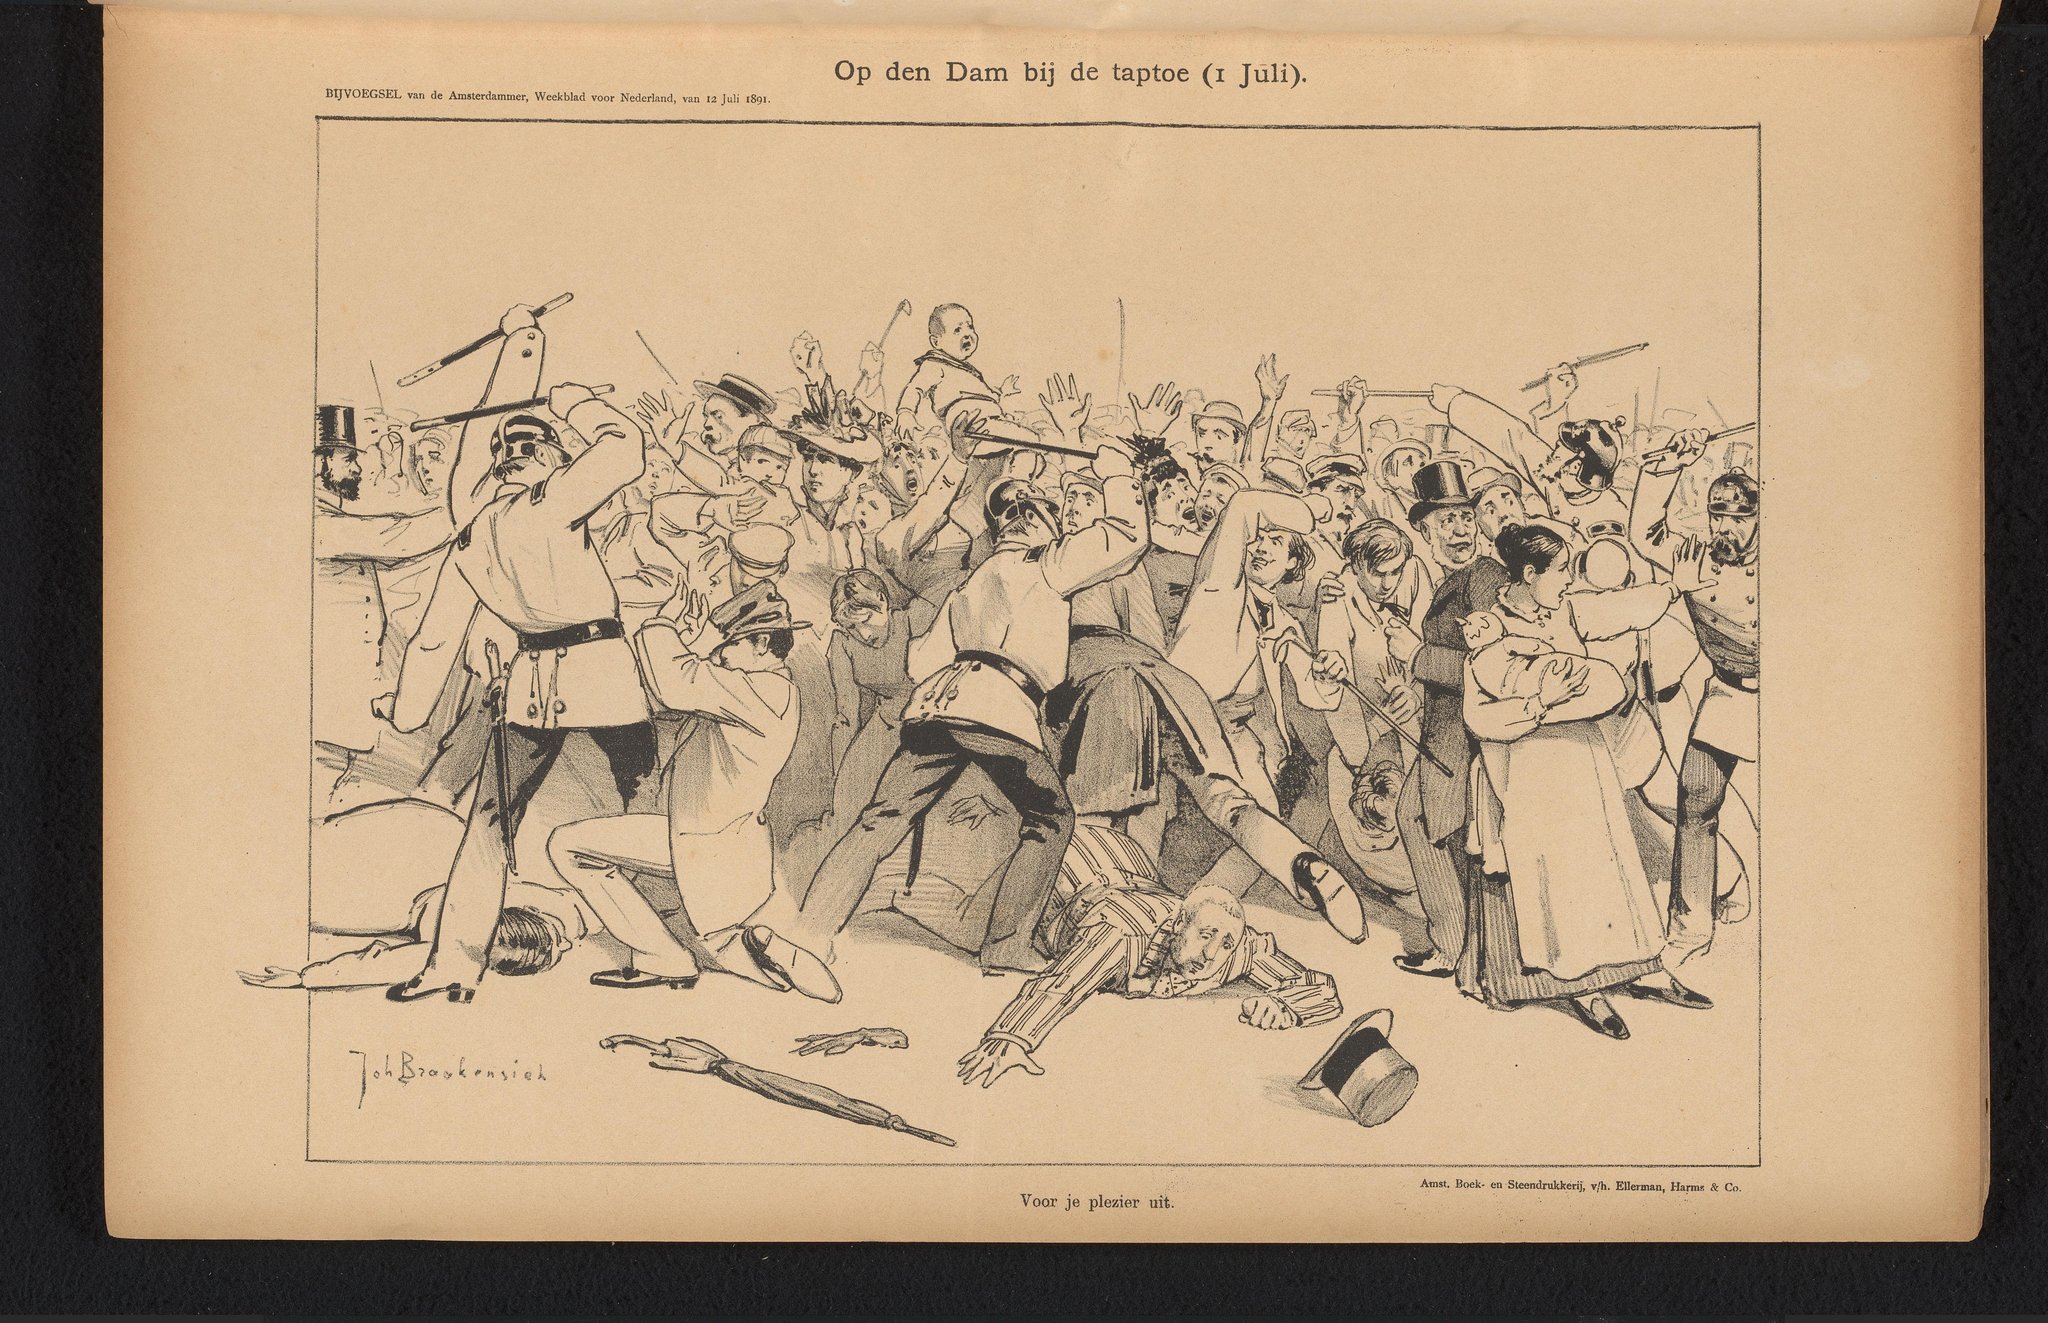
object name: cartoon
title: Op den Dam bij de taptoe (1 Juli)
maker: johan braakensiek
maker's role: draughtsman, print maker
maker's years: 1858-1940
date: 1891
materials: paper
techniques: lithograph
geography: amsterdam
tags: military band, political caricatures and satires, police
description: Het zgn. taptoeschandaal. De politie slaat met de wapenstok in op het publiek aanwezig bij de taptoe op de Dam op 1 juli 1891, ter ere van het bezoek van de Duitse keizer Wilhelm II.